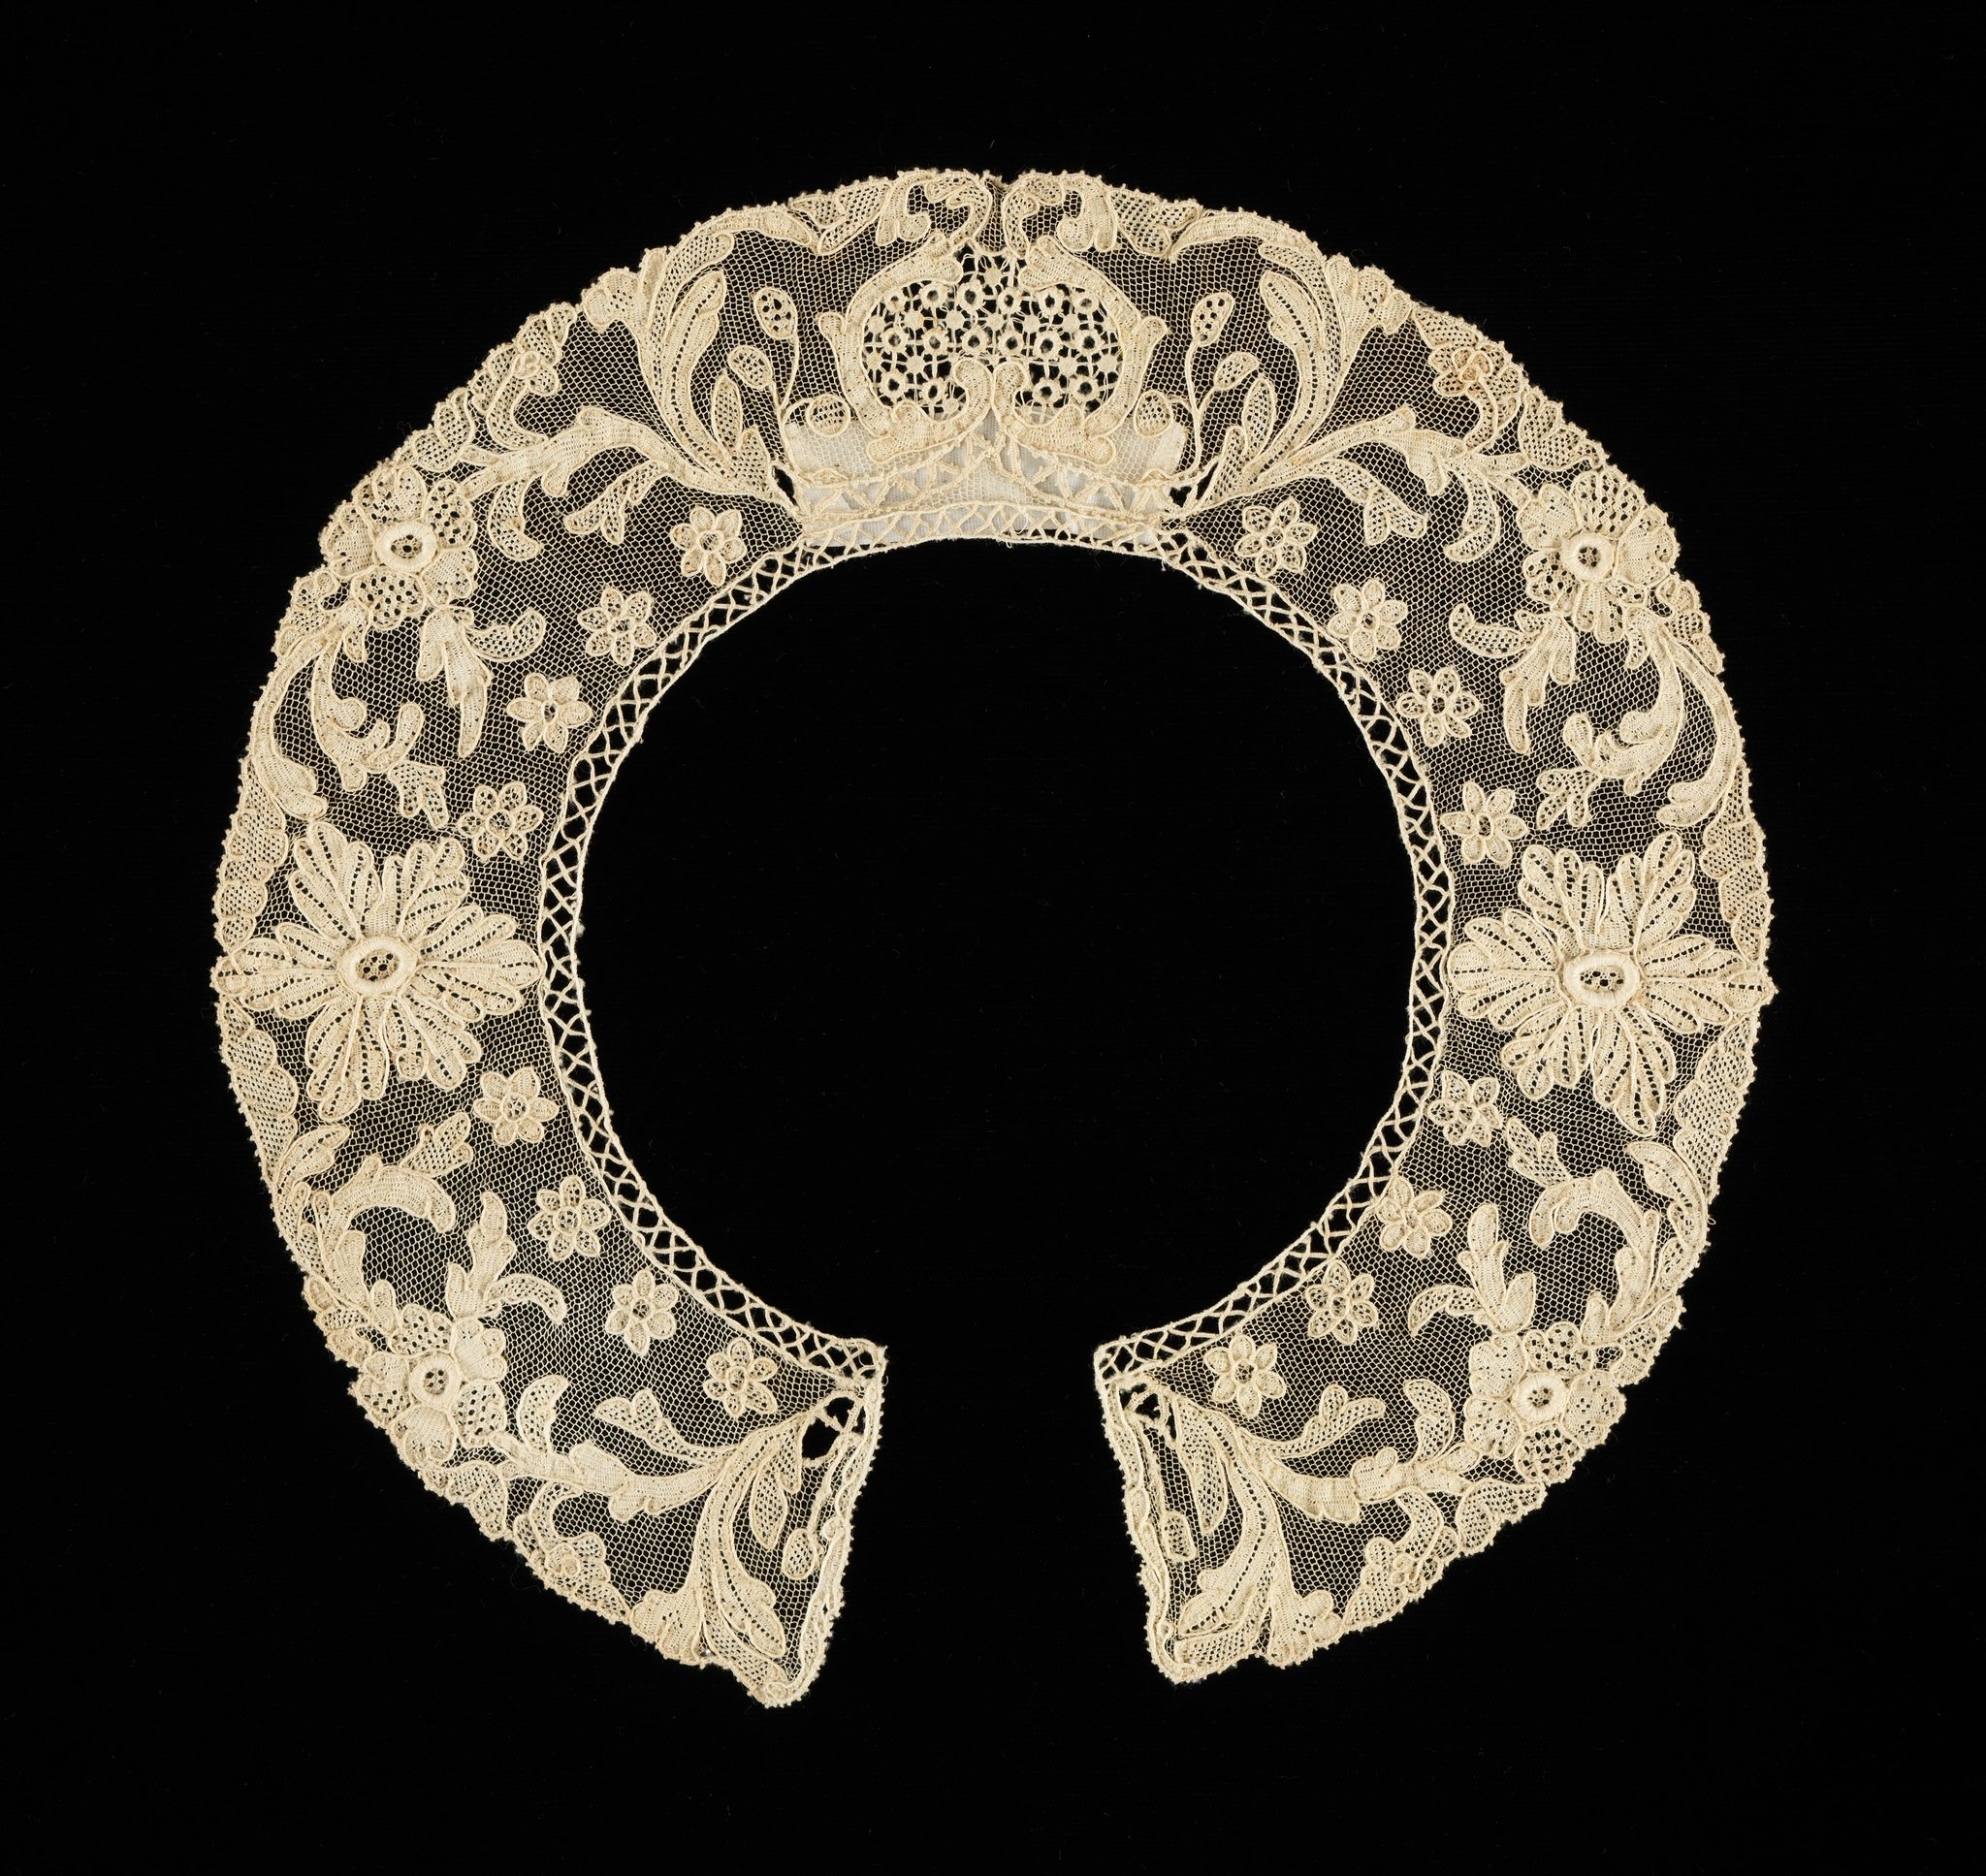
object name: collar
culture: italian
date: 1876-1900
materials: linen